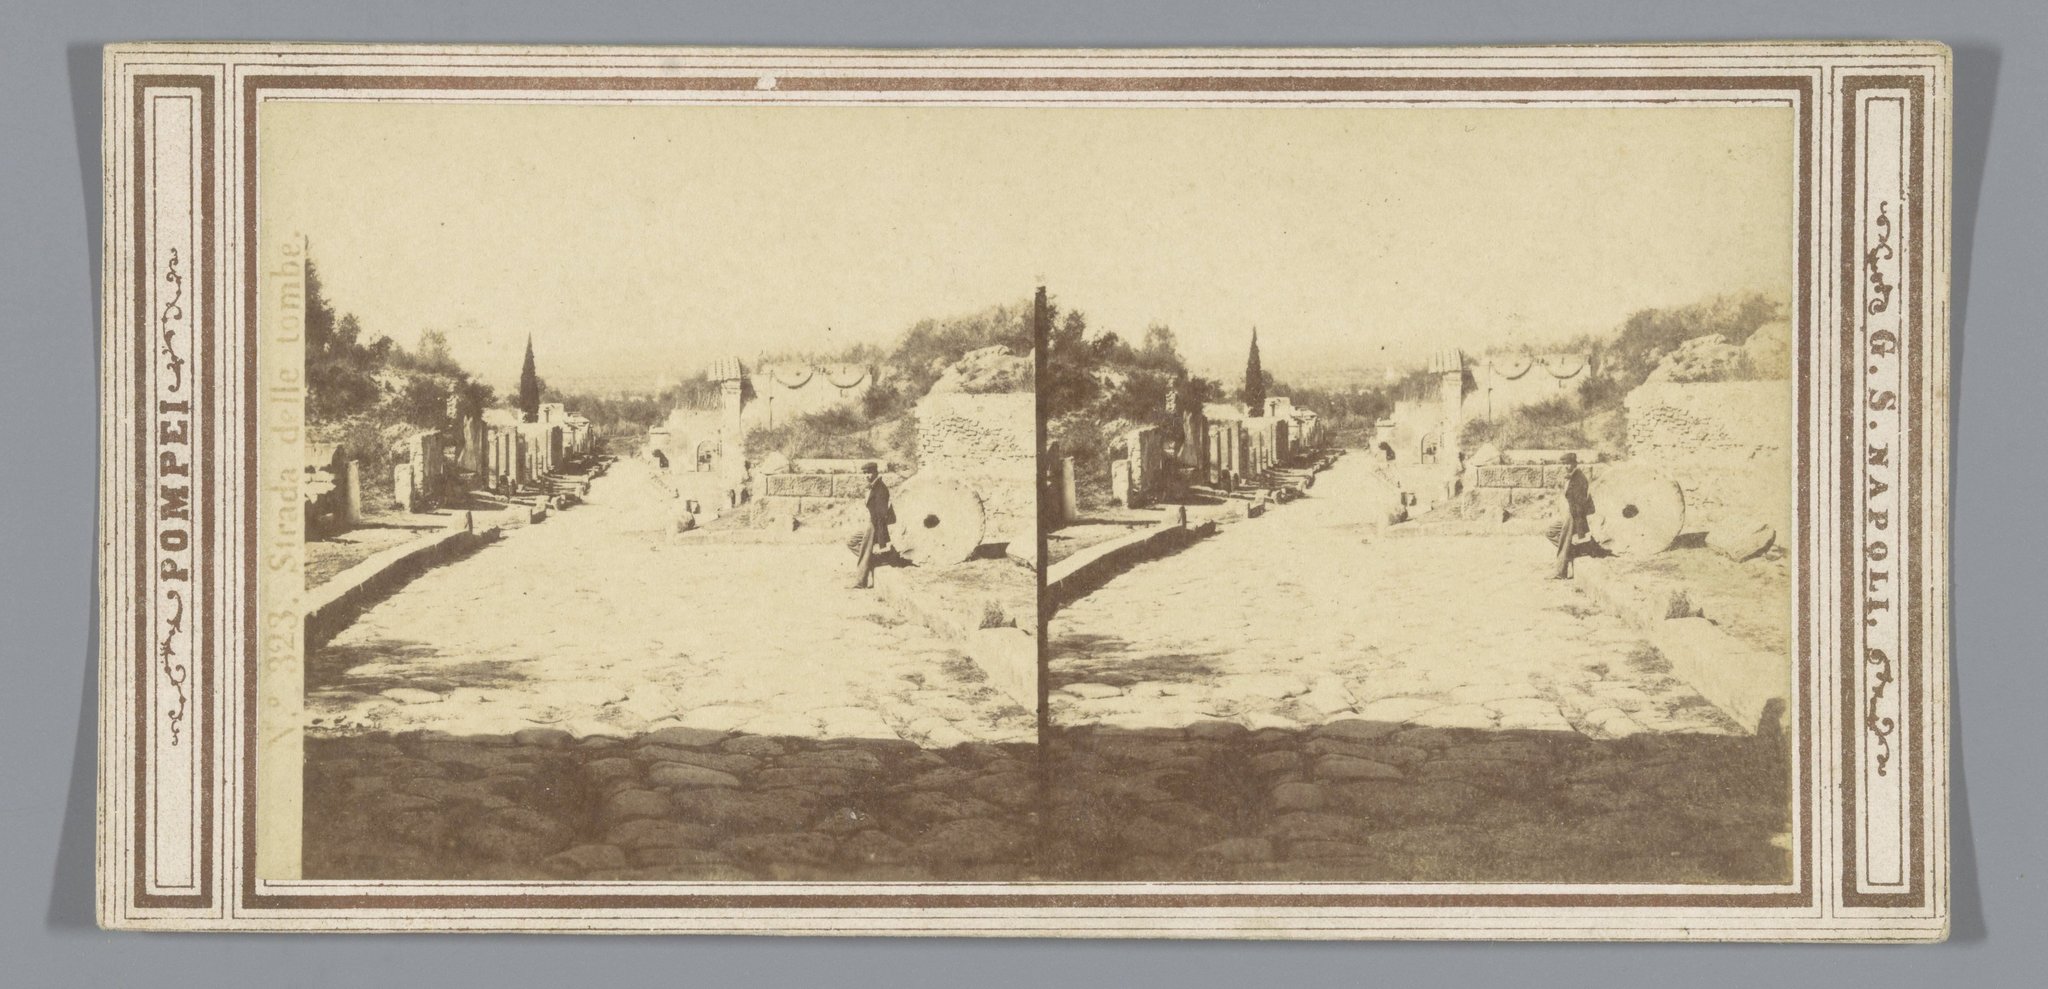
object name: stereograph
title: Gezicht op de Via delle Tombe Pompeï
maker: giorgio sommer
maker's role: fotograaf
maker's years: 1834-1914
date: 1860-1880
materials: cardboard, photographic support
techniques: albumen print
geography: pompeii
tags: landscape with ruins, street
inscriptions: number: ‘No. 323.’, number: ‘L. 3.’